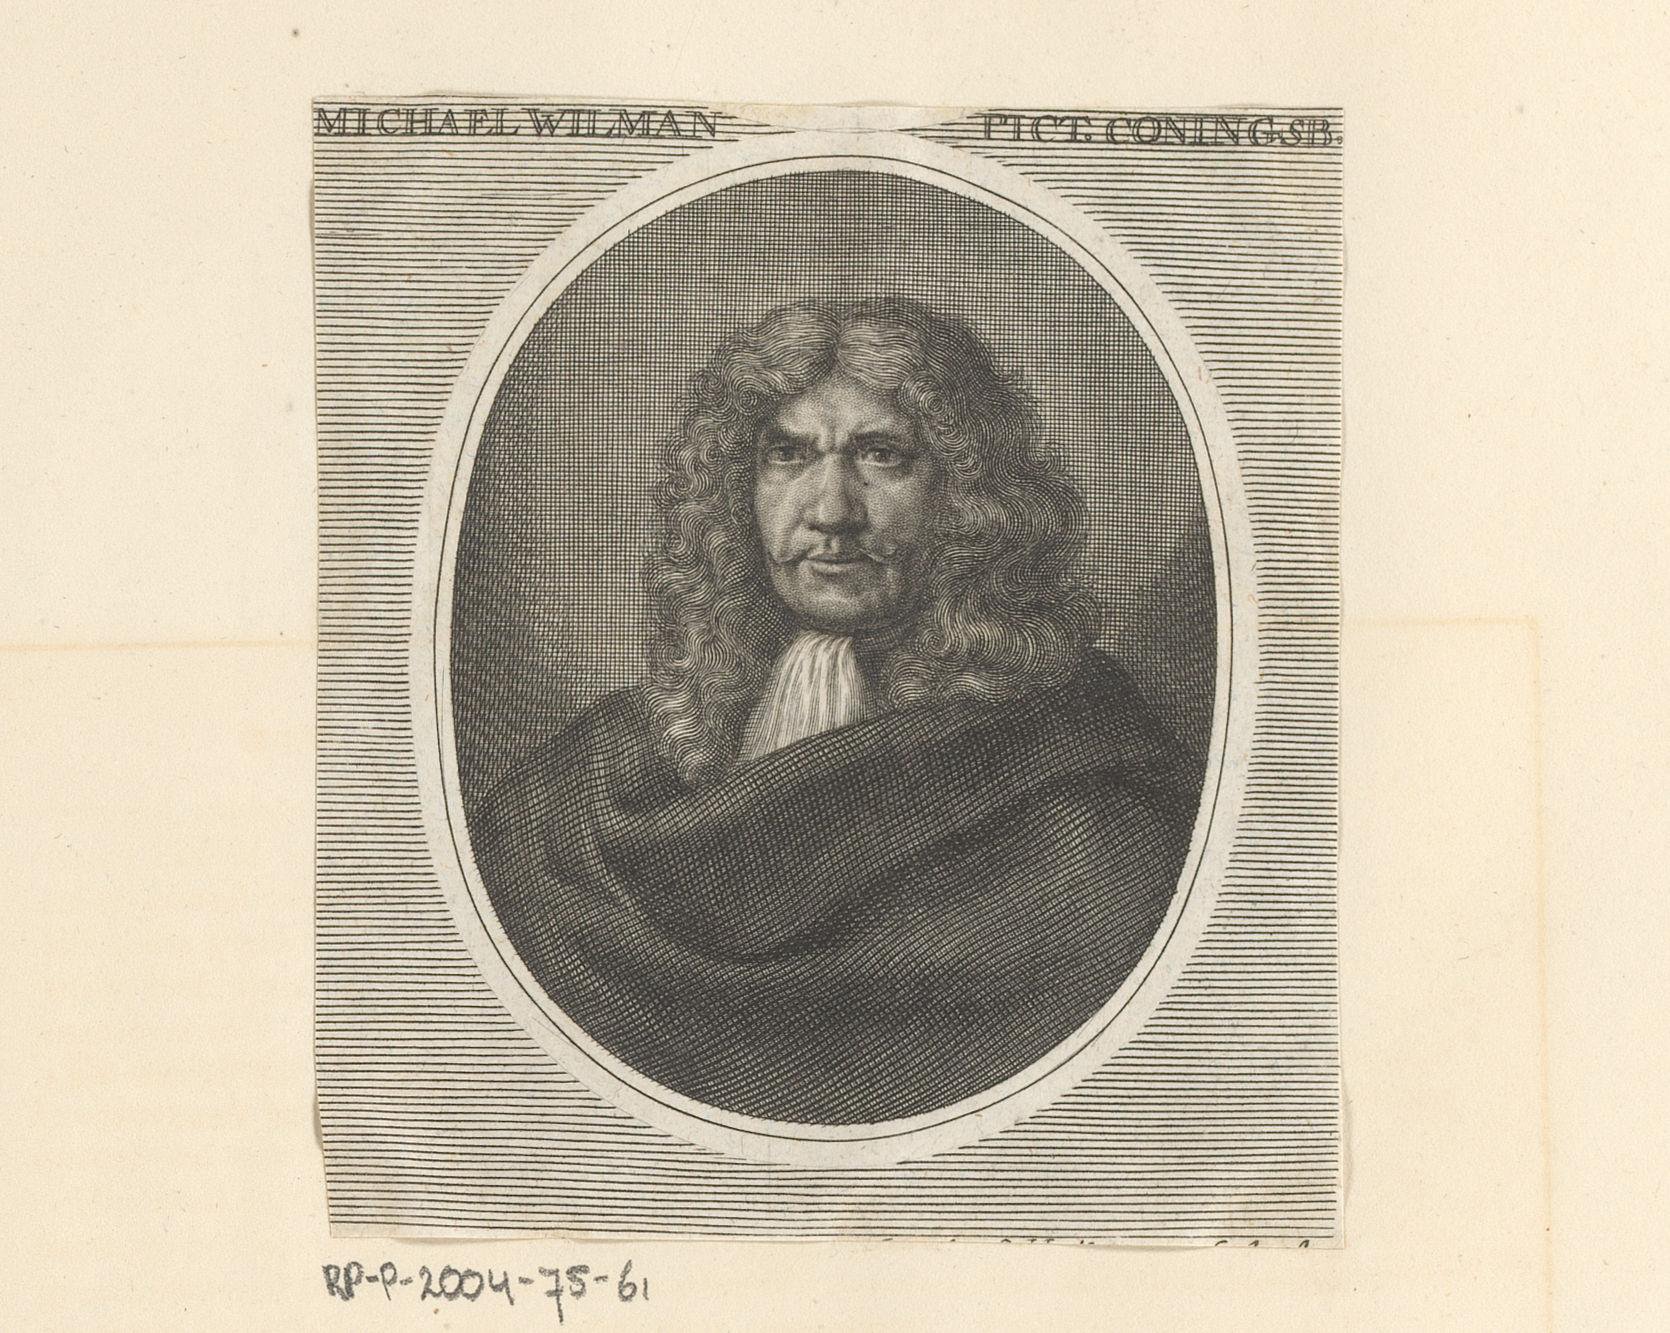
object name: print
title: Portret van Michaël Lukas Leopold Willmann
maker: leonhard heckenauer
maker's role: print maker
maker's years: 1650-1704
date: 1769-1775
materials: paper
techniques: engraving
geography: nuremberg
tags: leubus, print maker, draughtsman, michael willmann, historical persons, portrait, self-portrait of painter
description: Prent uit: Sandrart, Joachim von. Teutsche Academie der Bau- Bildhauer- und Maler-Kunst: worinn die Regeln und Lehrsätze dieser Künste gegeben. 14 dln. Neurenberg: erven Johann Andreas Endter, [1774], dl. 7, p. SS. De samensteller heeft deze prent in het album geplakt als illustratie bij: Pilkington, Matthew en Johann Heinrich Füssli. A dictionary of painters, from the revival of the art to the present period. 4 dln. Londen: John Crowder, 1805, dl. 4, p. 648.